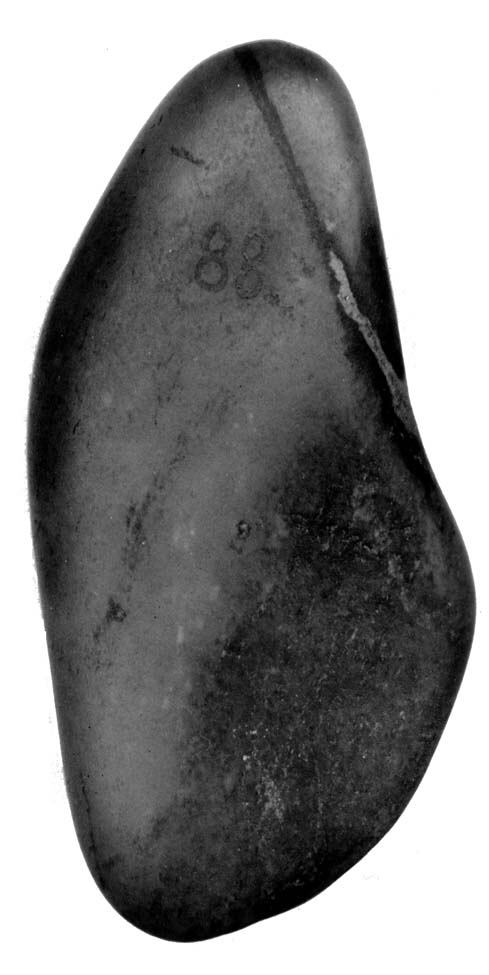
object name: pebble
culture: chinese or turkestani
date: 1902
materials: jade